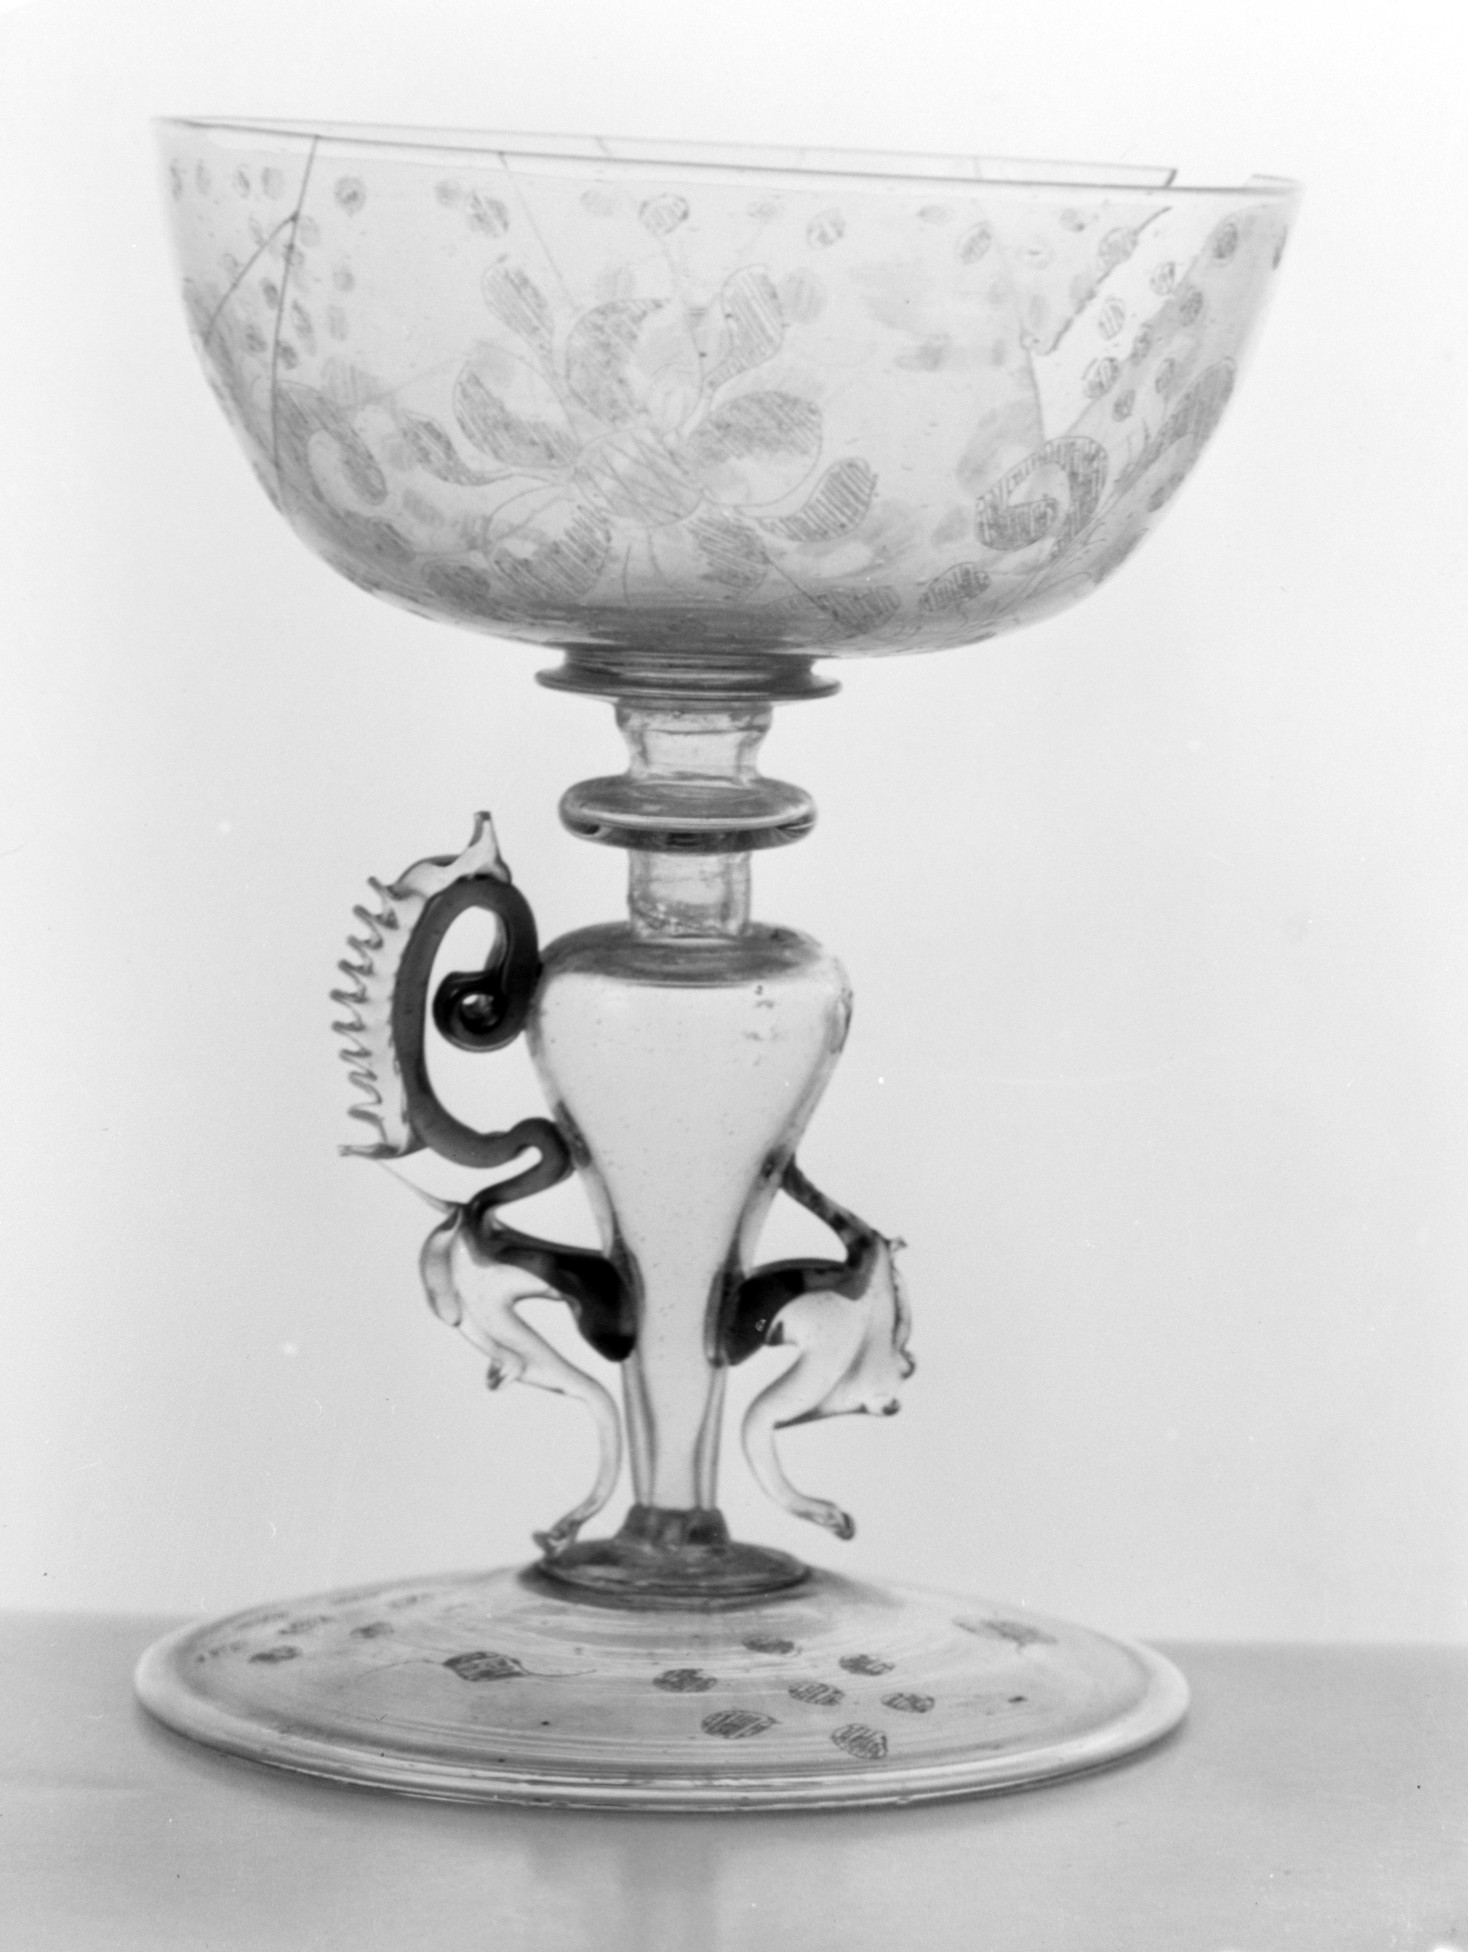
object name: goblet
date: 1601-1700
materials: glass